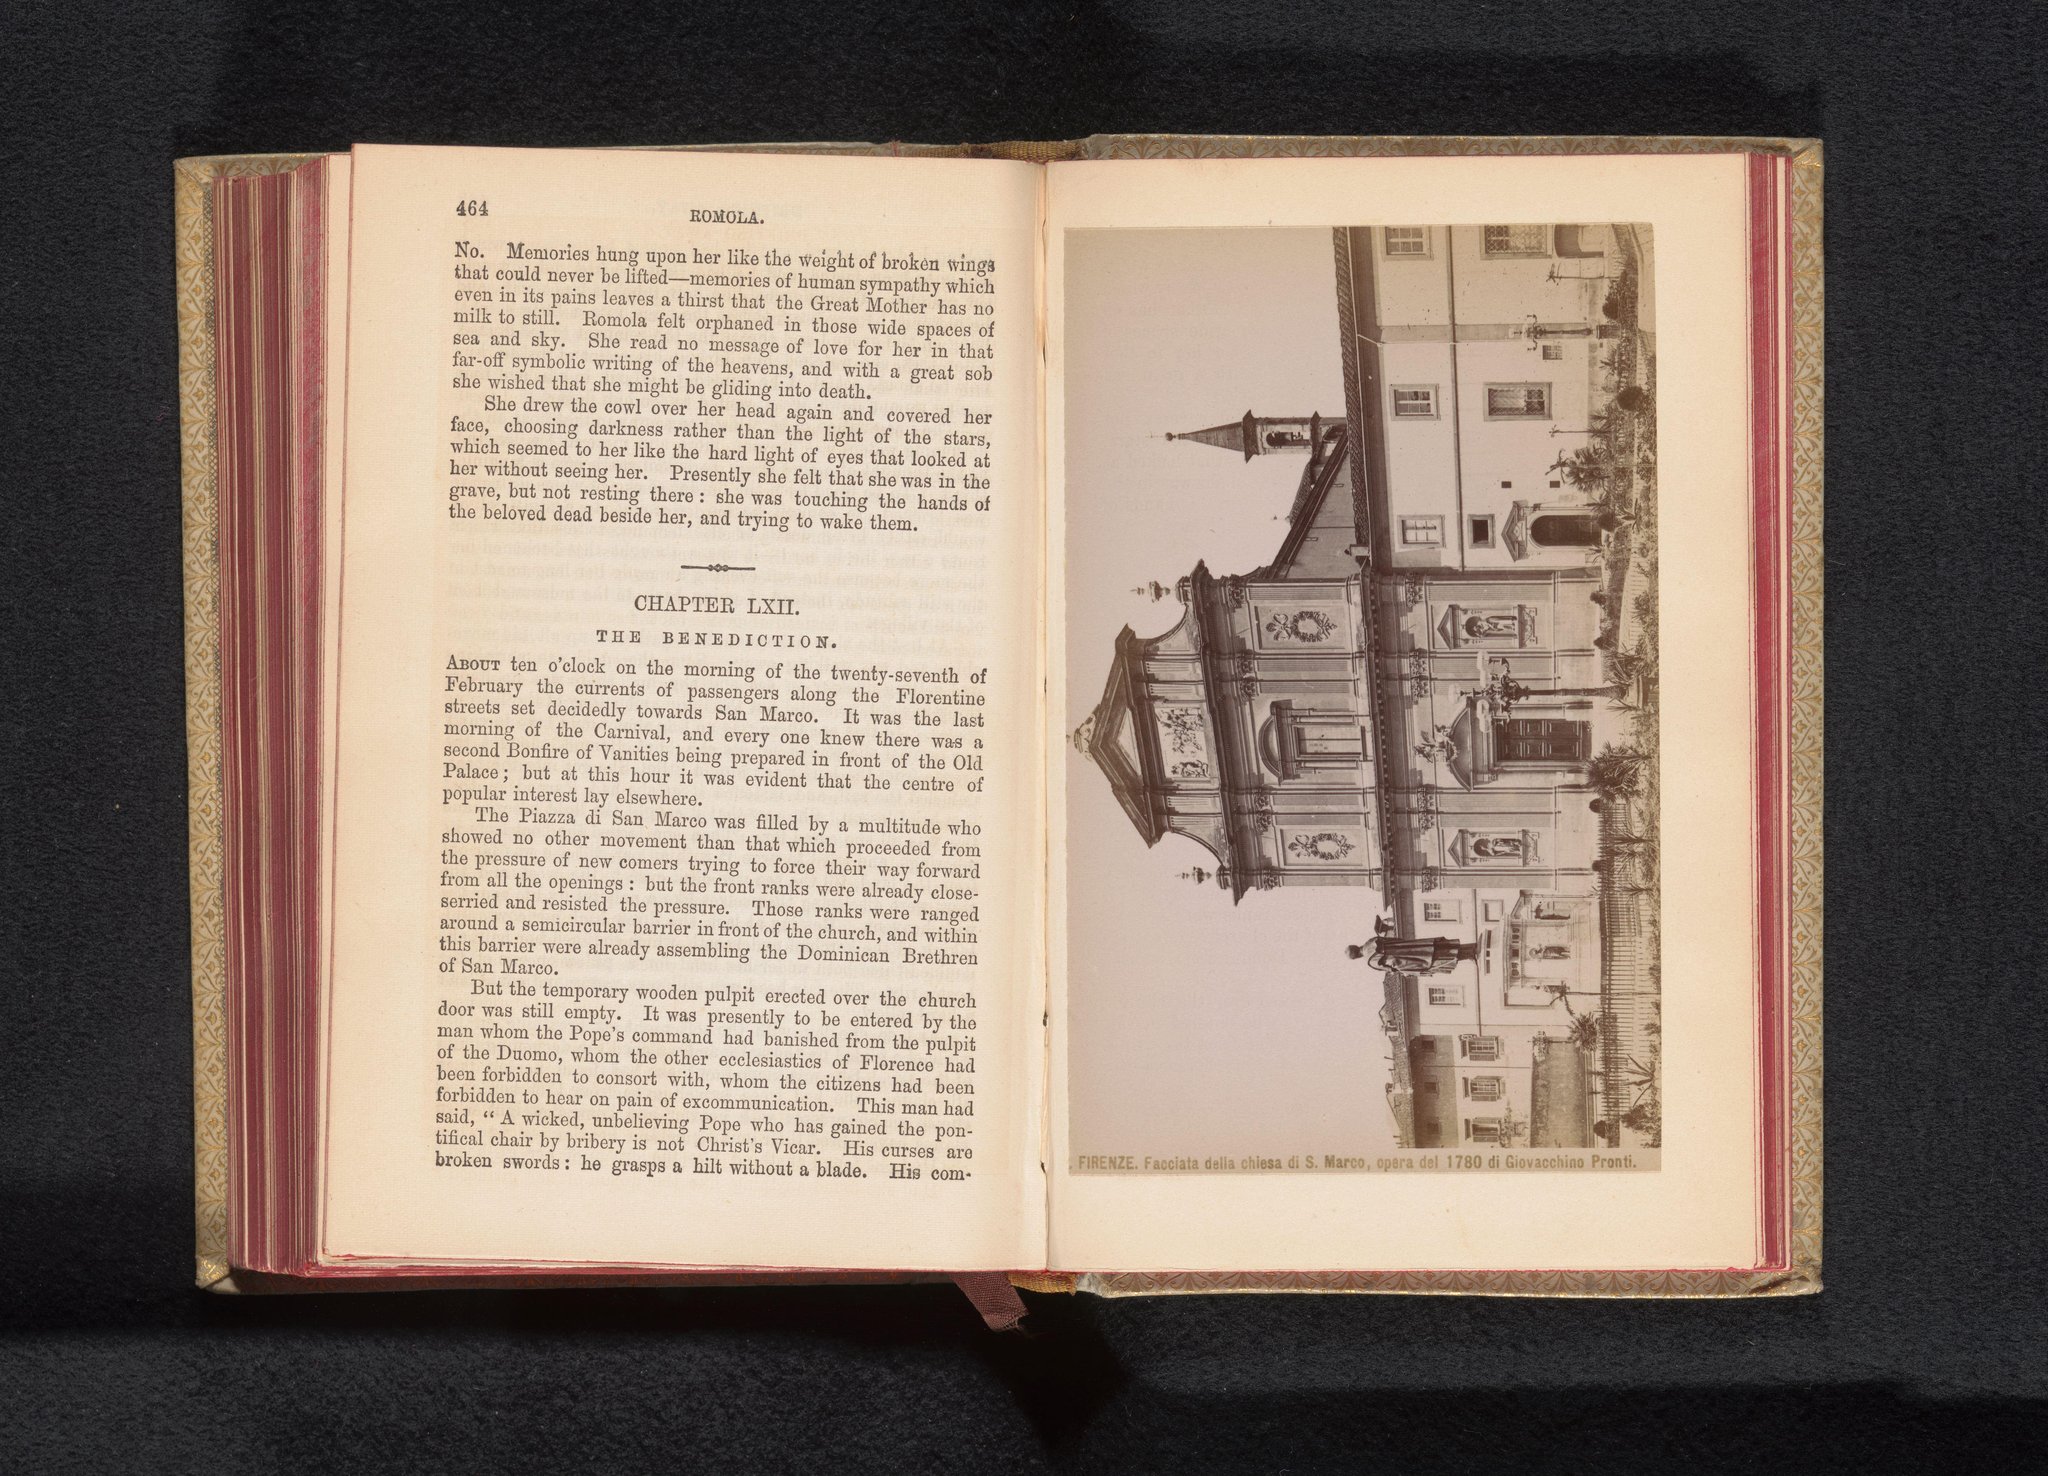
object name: page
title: Firenze. Facciata della chiesa di S. Marco, opera dei 1780 di Giovacchino Pronti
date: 1878-1888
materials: photographic support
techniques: albumen print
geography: florence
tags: church (exterior), façade (of house or building)